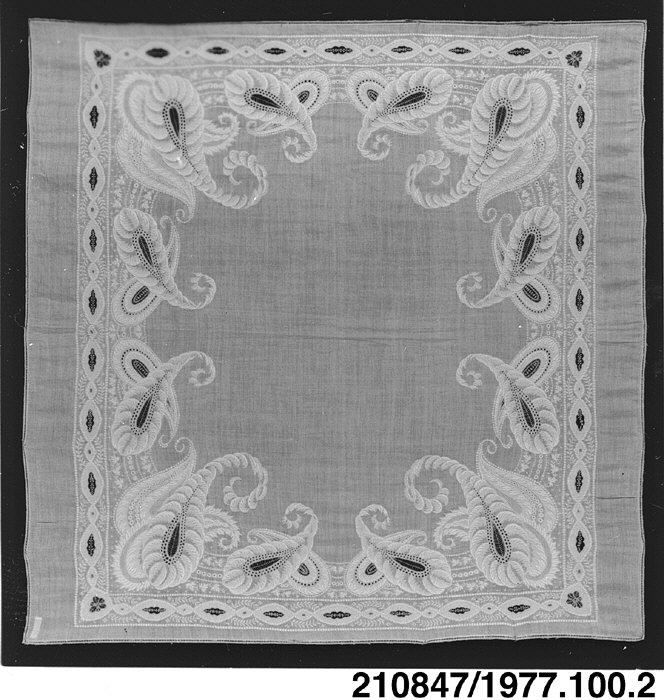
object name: pillow sham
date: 1860-1869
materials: linen